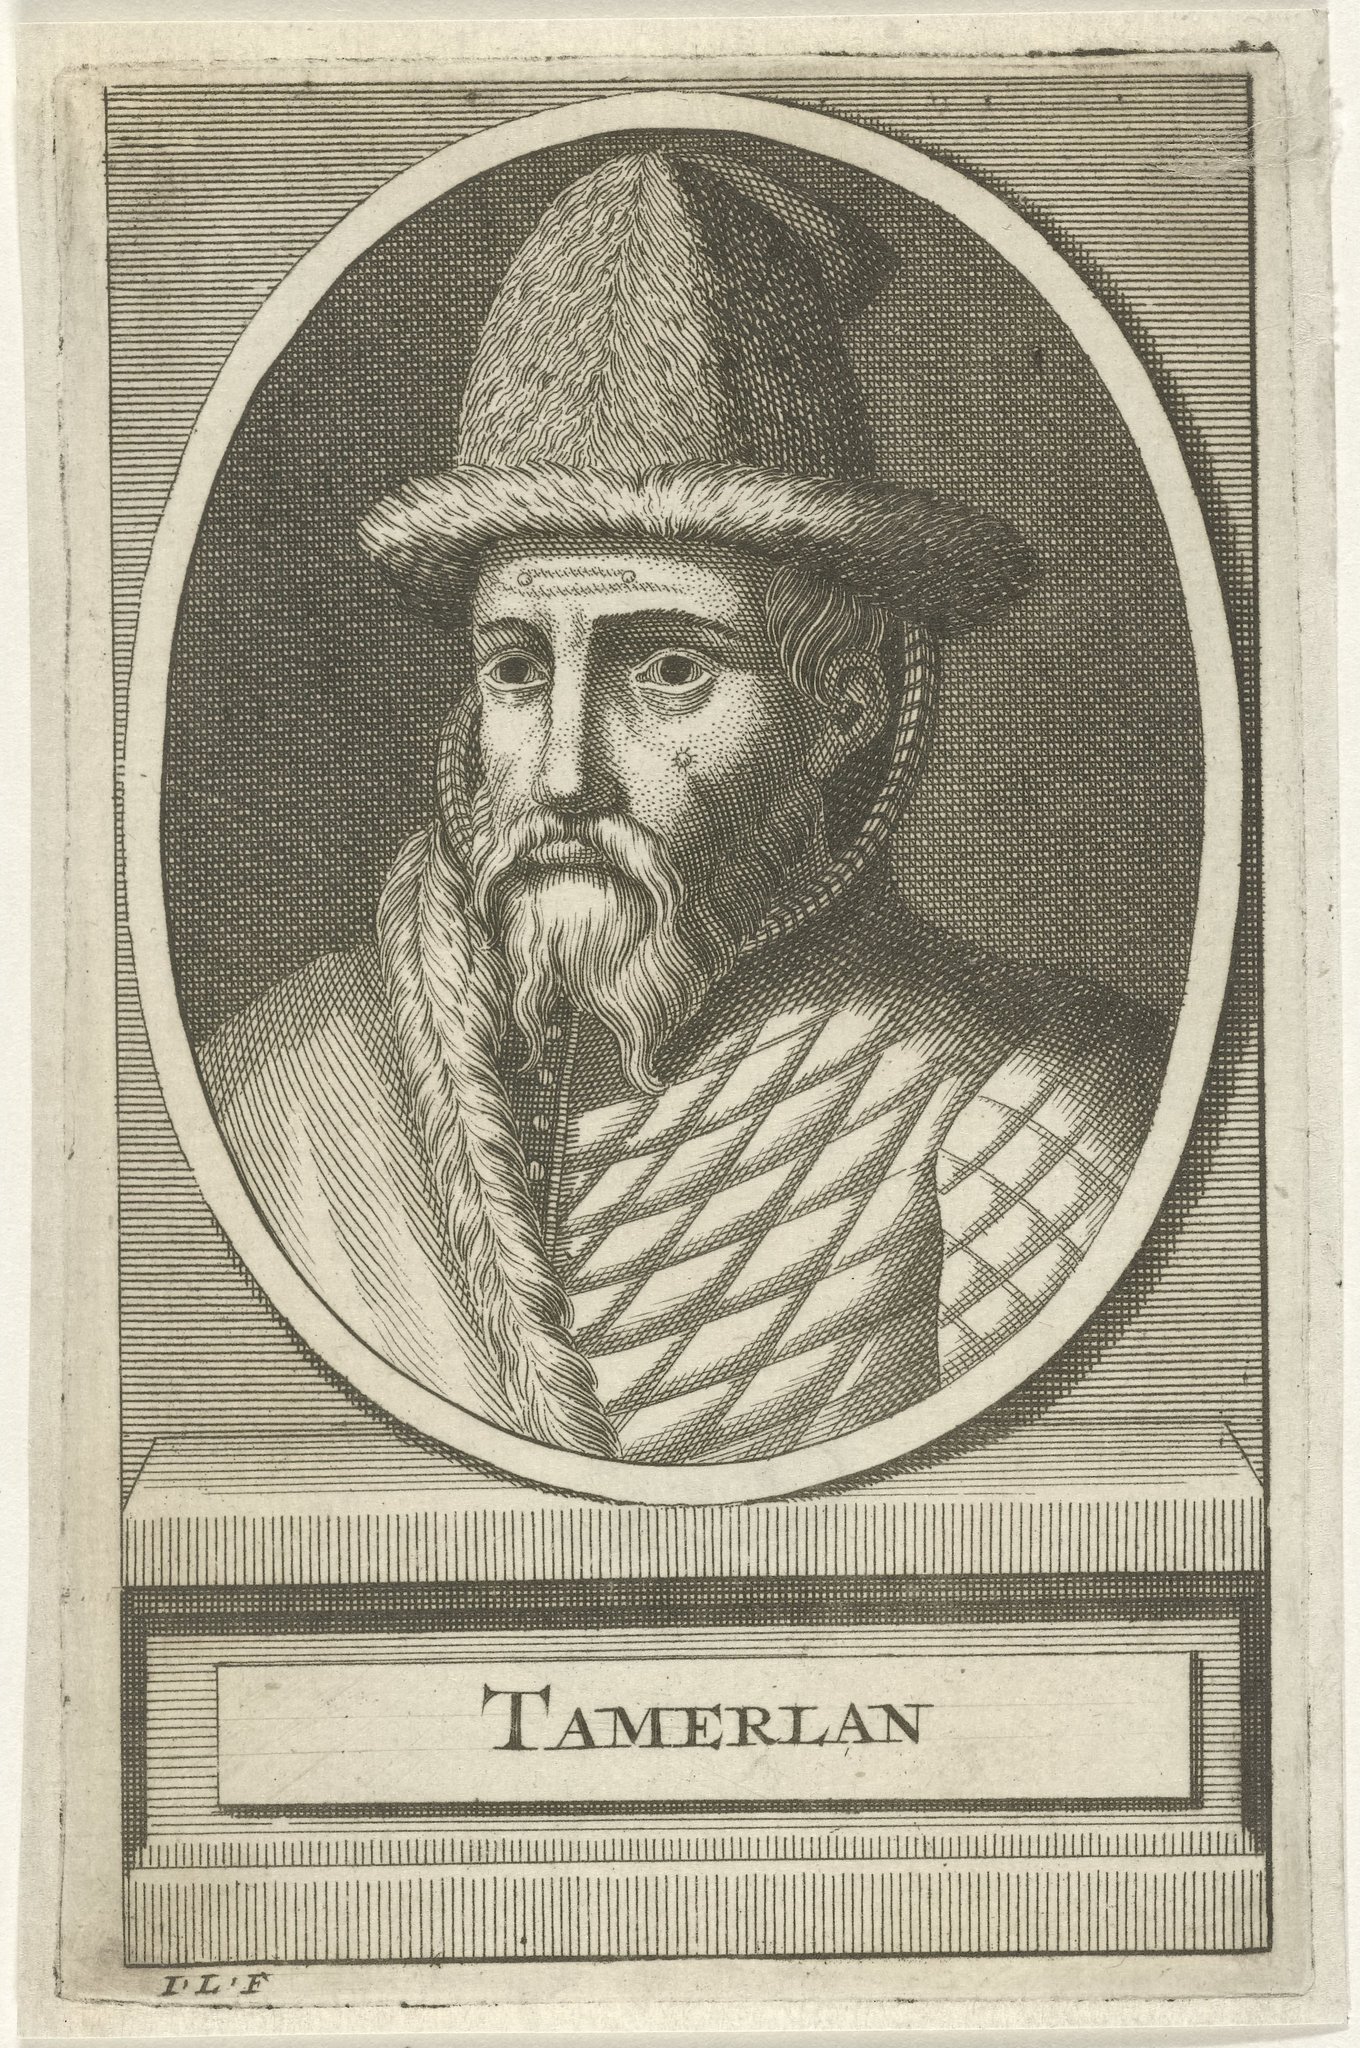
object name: print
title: Tamerlan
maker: jan lamsvelt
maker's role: print maker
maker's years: 1674-1743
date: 1684-1743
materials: paper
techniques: engraving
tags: krijgsman, timoer lenk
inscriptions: collector's mark: Lugt 2228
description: Portretbuste in ovaal naar links van Timoer Lenk, stichter van het Timoeridische rijk, met bontmuts. Het portret steunt op een sokkel waarop de naam van de geportretteerde staat.